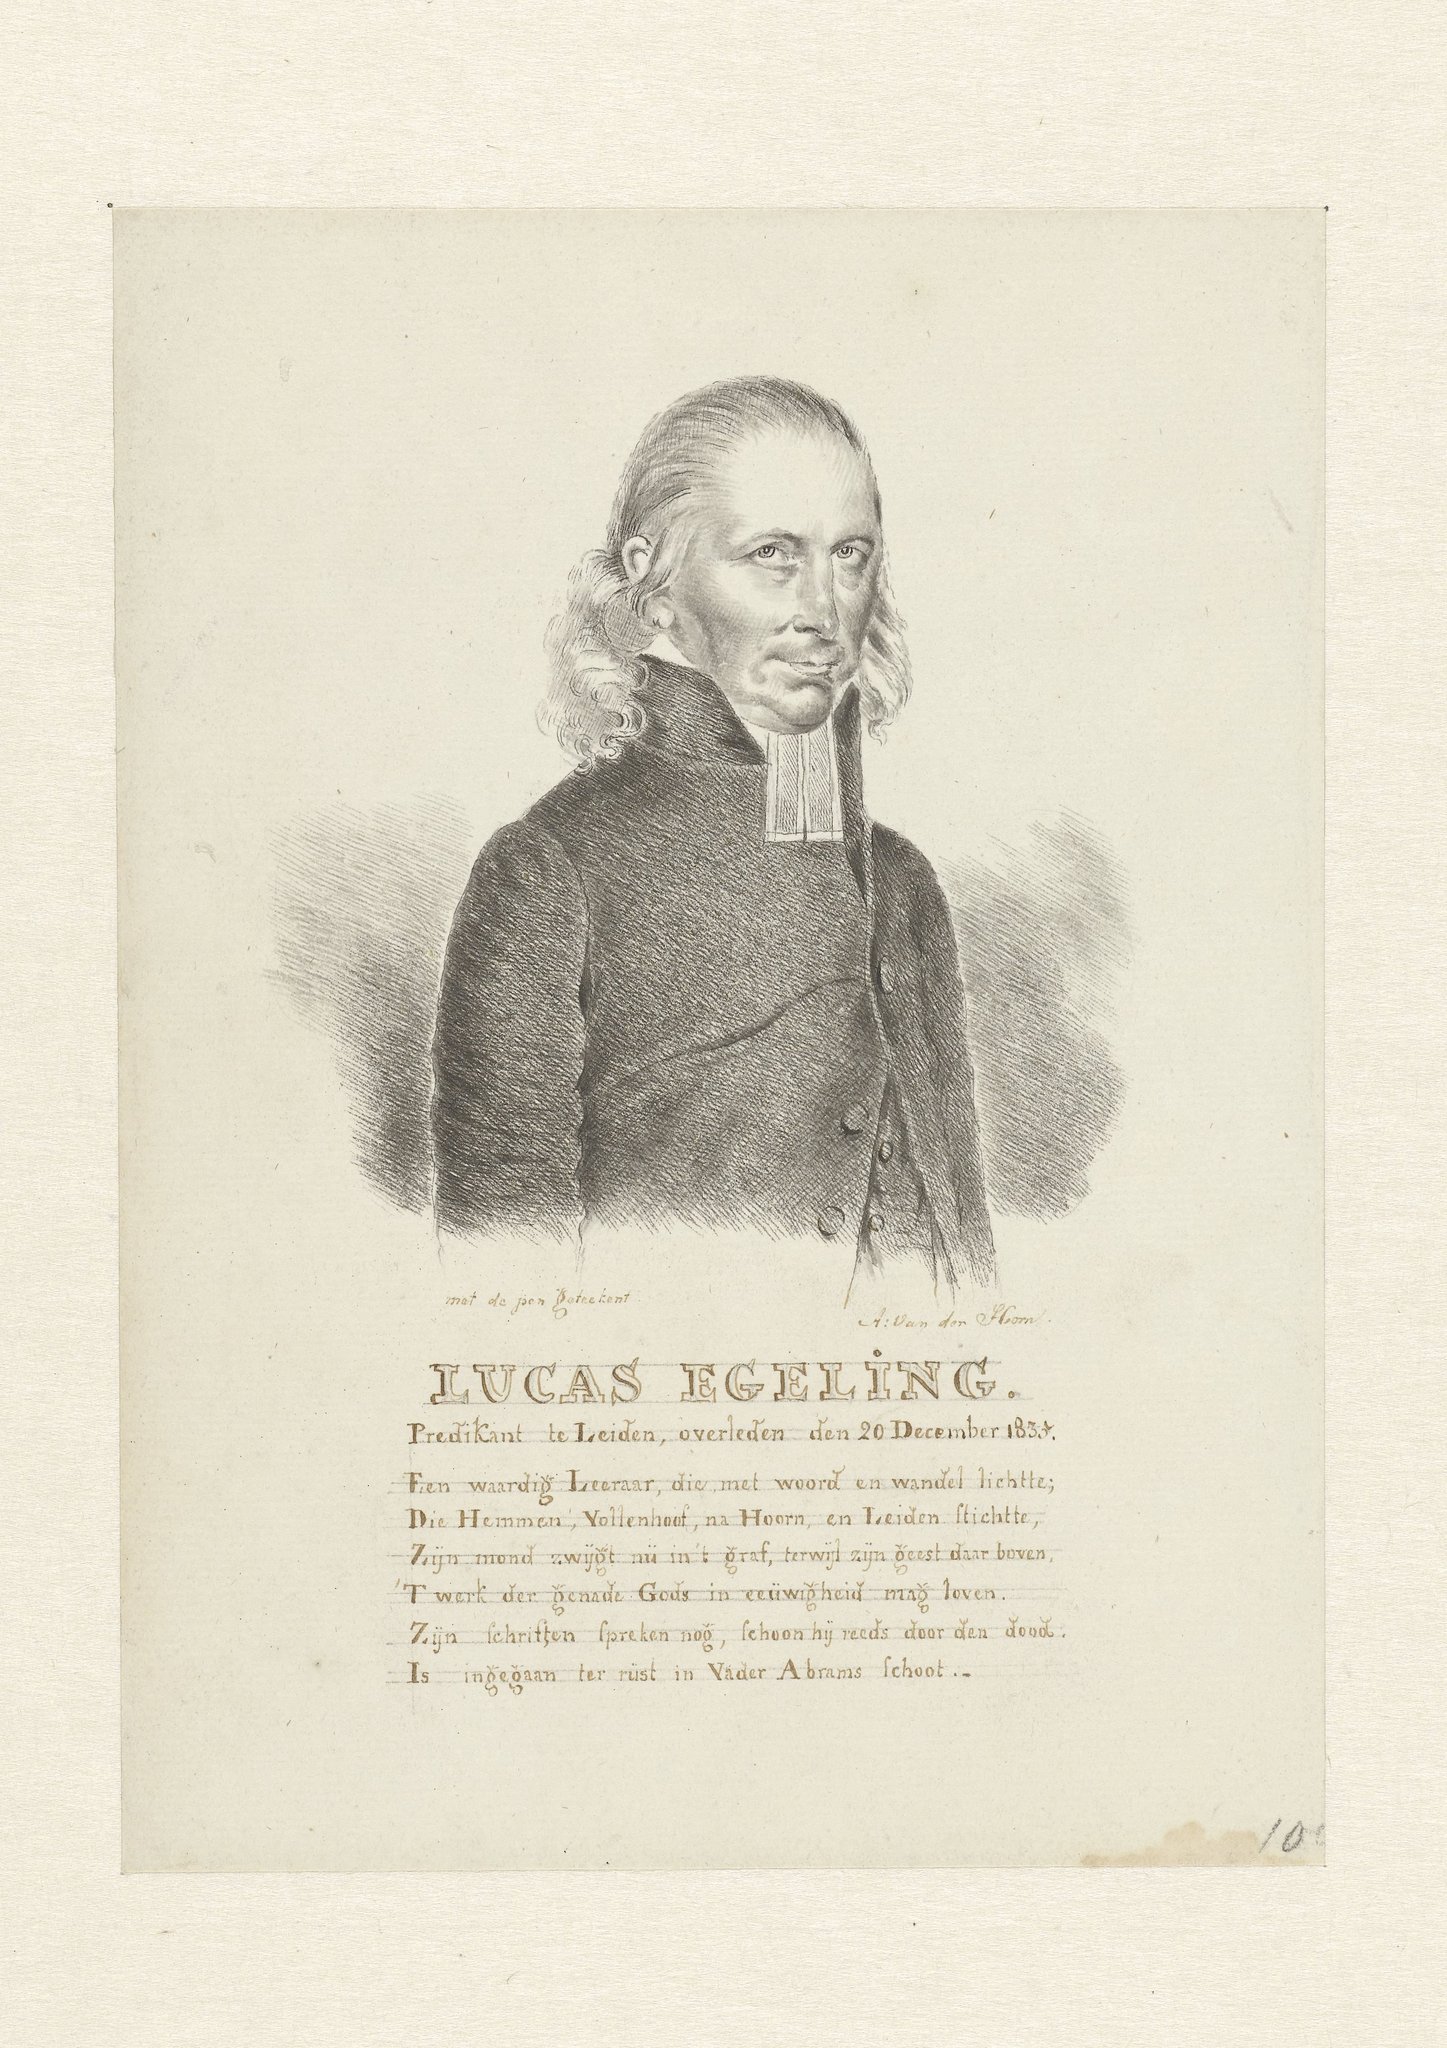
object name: drawing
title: Portret van Lucas Egeling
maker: abram van der horn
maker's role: draughtsman, print maker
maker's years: 1782-1867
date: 1792-1867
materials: ink, paper, pencil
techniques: brush, pen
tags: historical persons